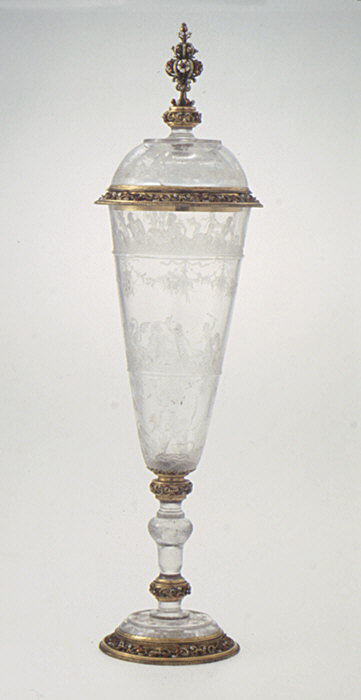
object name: standing cup with cover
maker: reinhold vasters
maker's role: designer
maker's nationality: german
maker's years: 1827-1909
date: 1851-1900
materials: enamel, gold, quartz